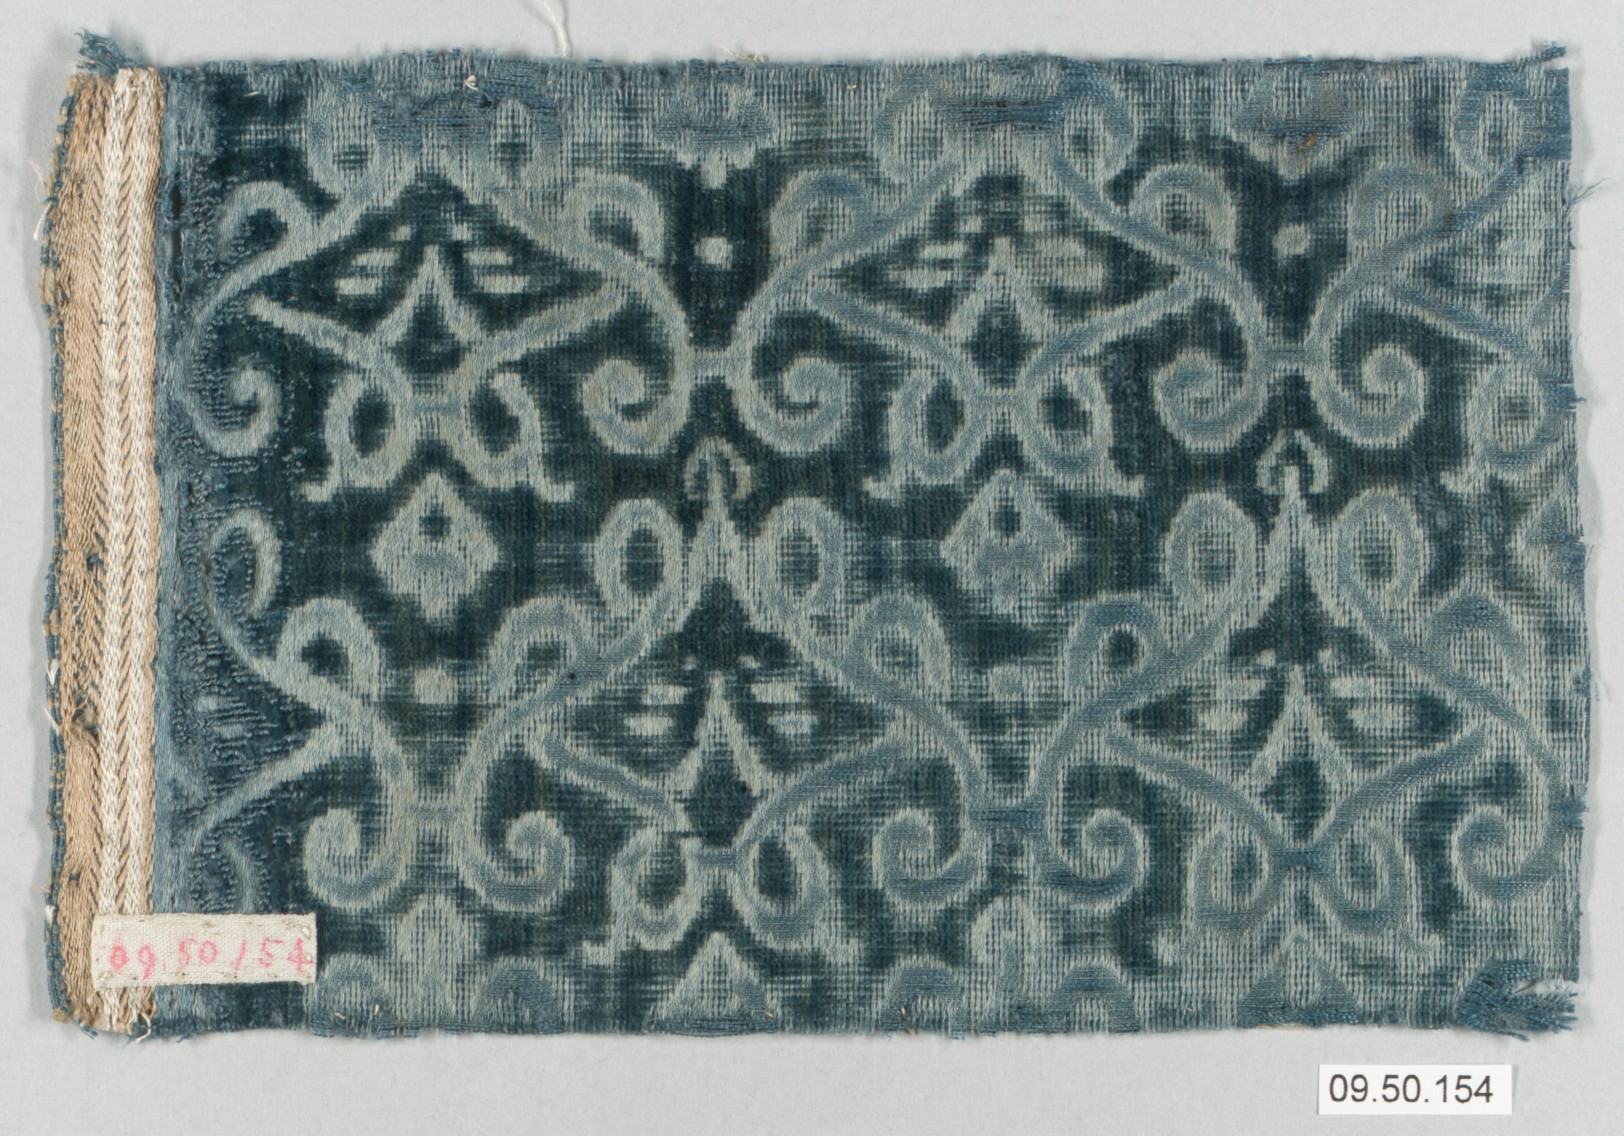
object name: piece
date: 1501-1700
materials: silk